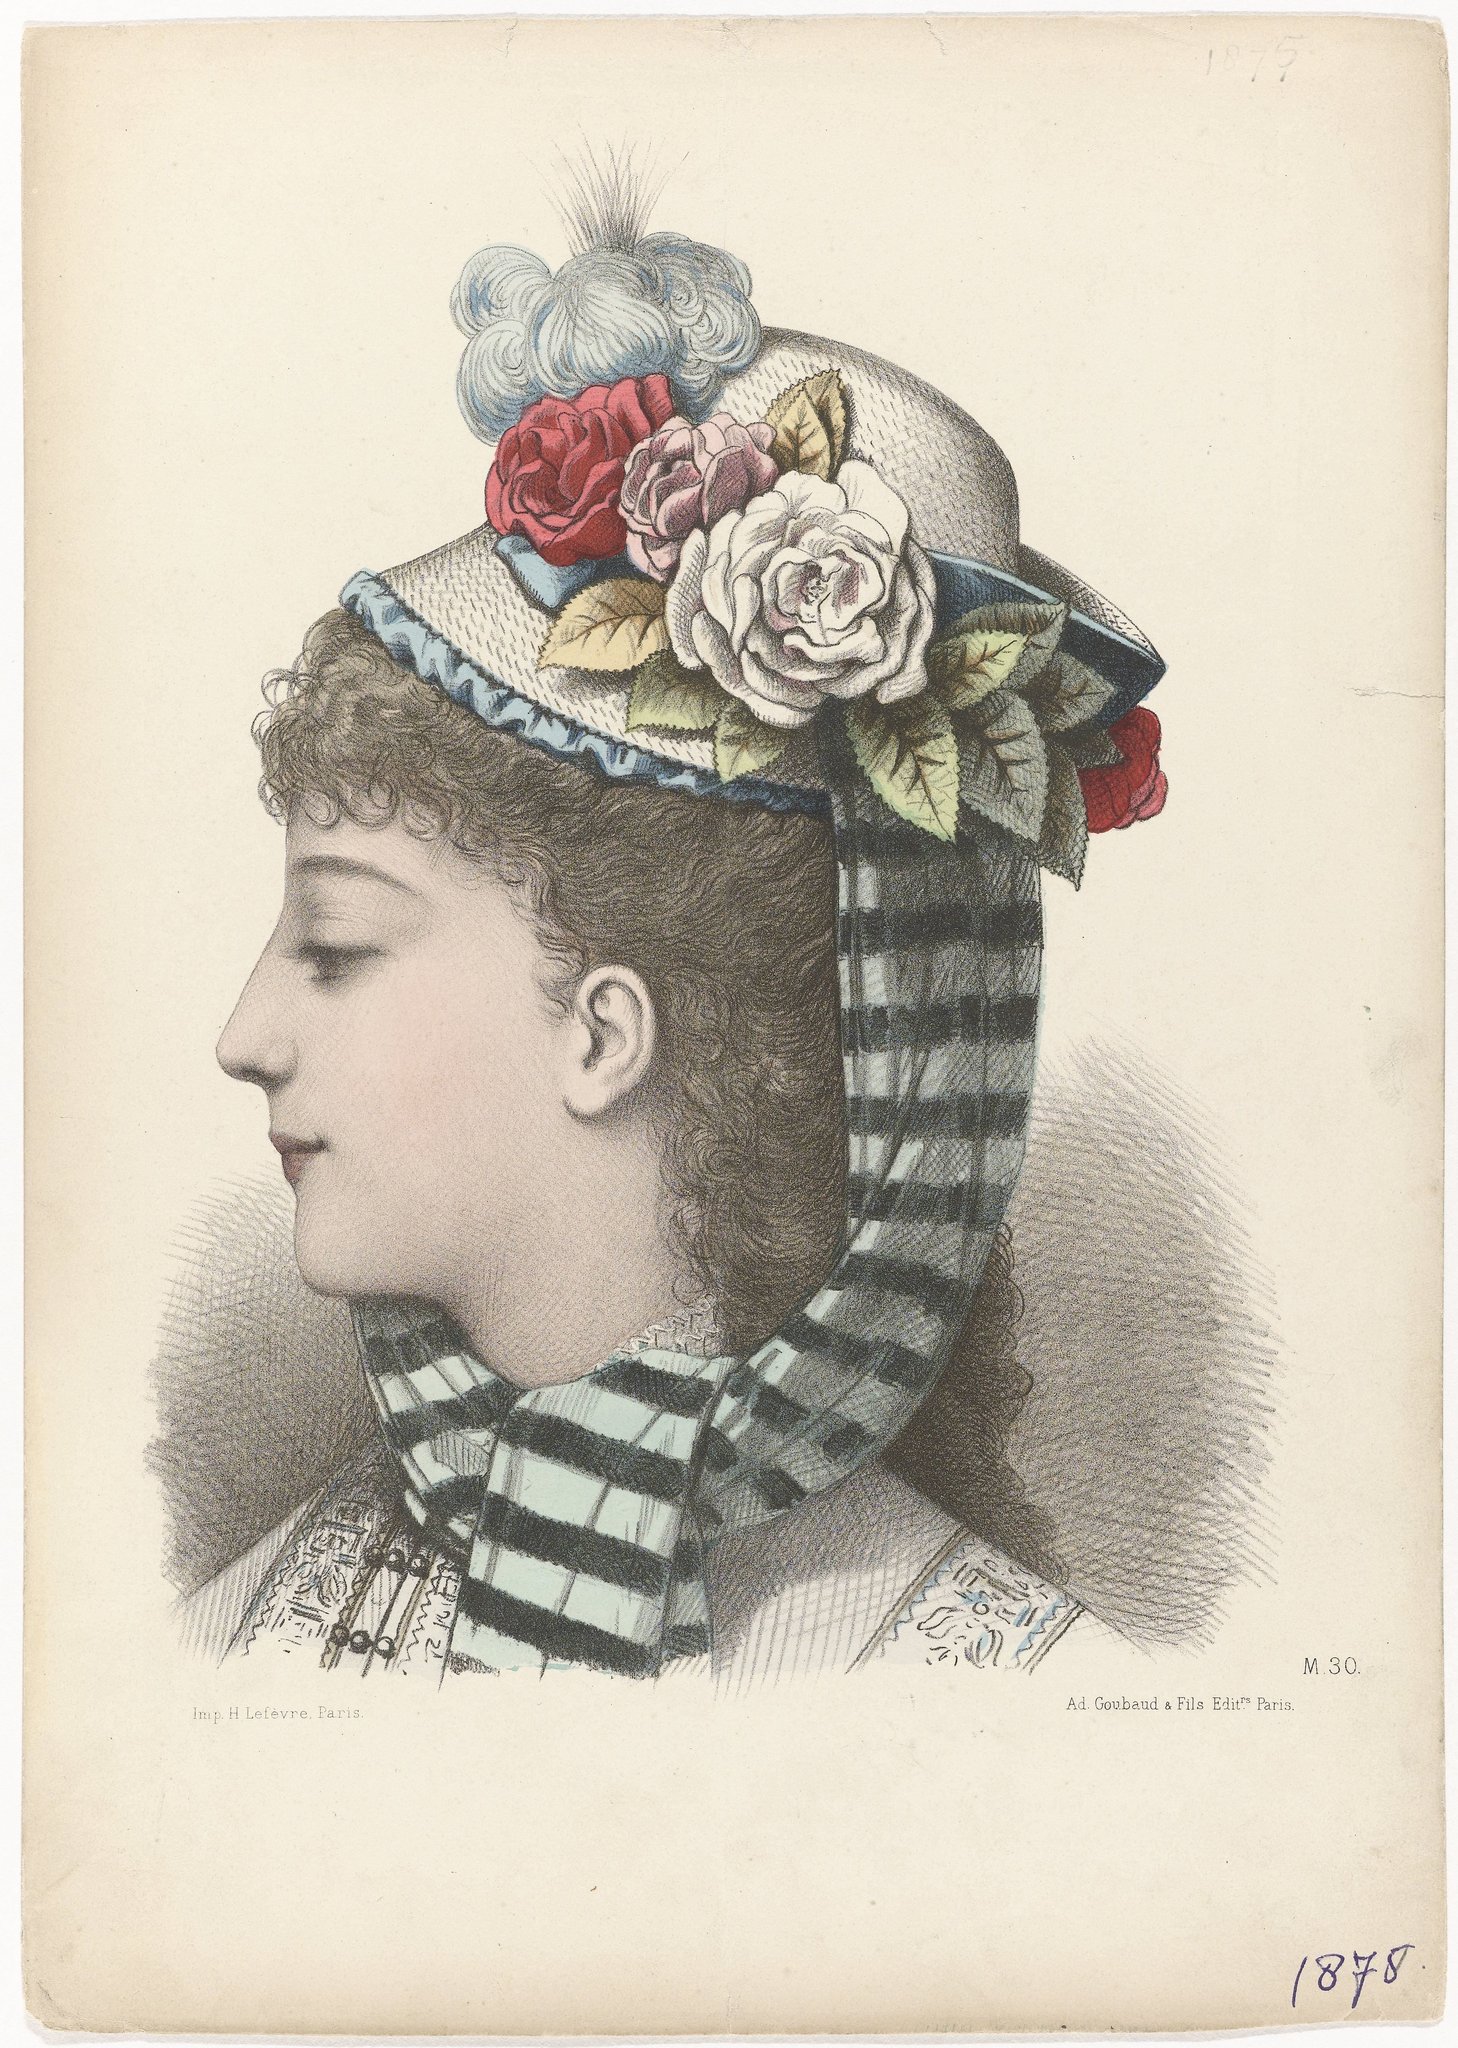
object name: fashion print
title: Vrouwenhoofd met hoed met rozen, 1875, No. M.30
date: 1875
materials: paper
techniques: hand coloring, lithograph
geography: paris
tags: flowers, border, ribbon, braid (+ women's clothes), fashion plates, head-gear: hat (+ women's clothes), head turned to the left - aa - female human figure, flowers: rose, head-gear: hat (+ feathers used for clothes)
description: Vrouwenhoofd, en profil naar links, met een hoed versierd met pluimen, rozen en gestreepte striklinten.